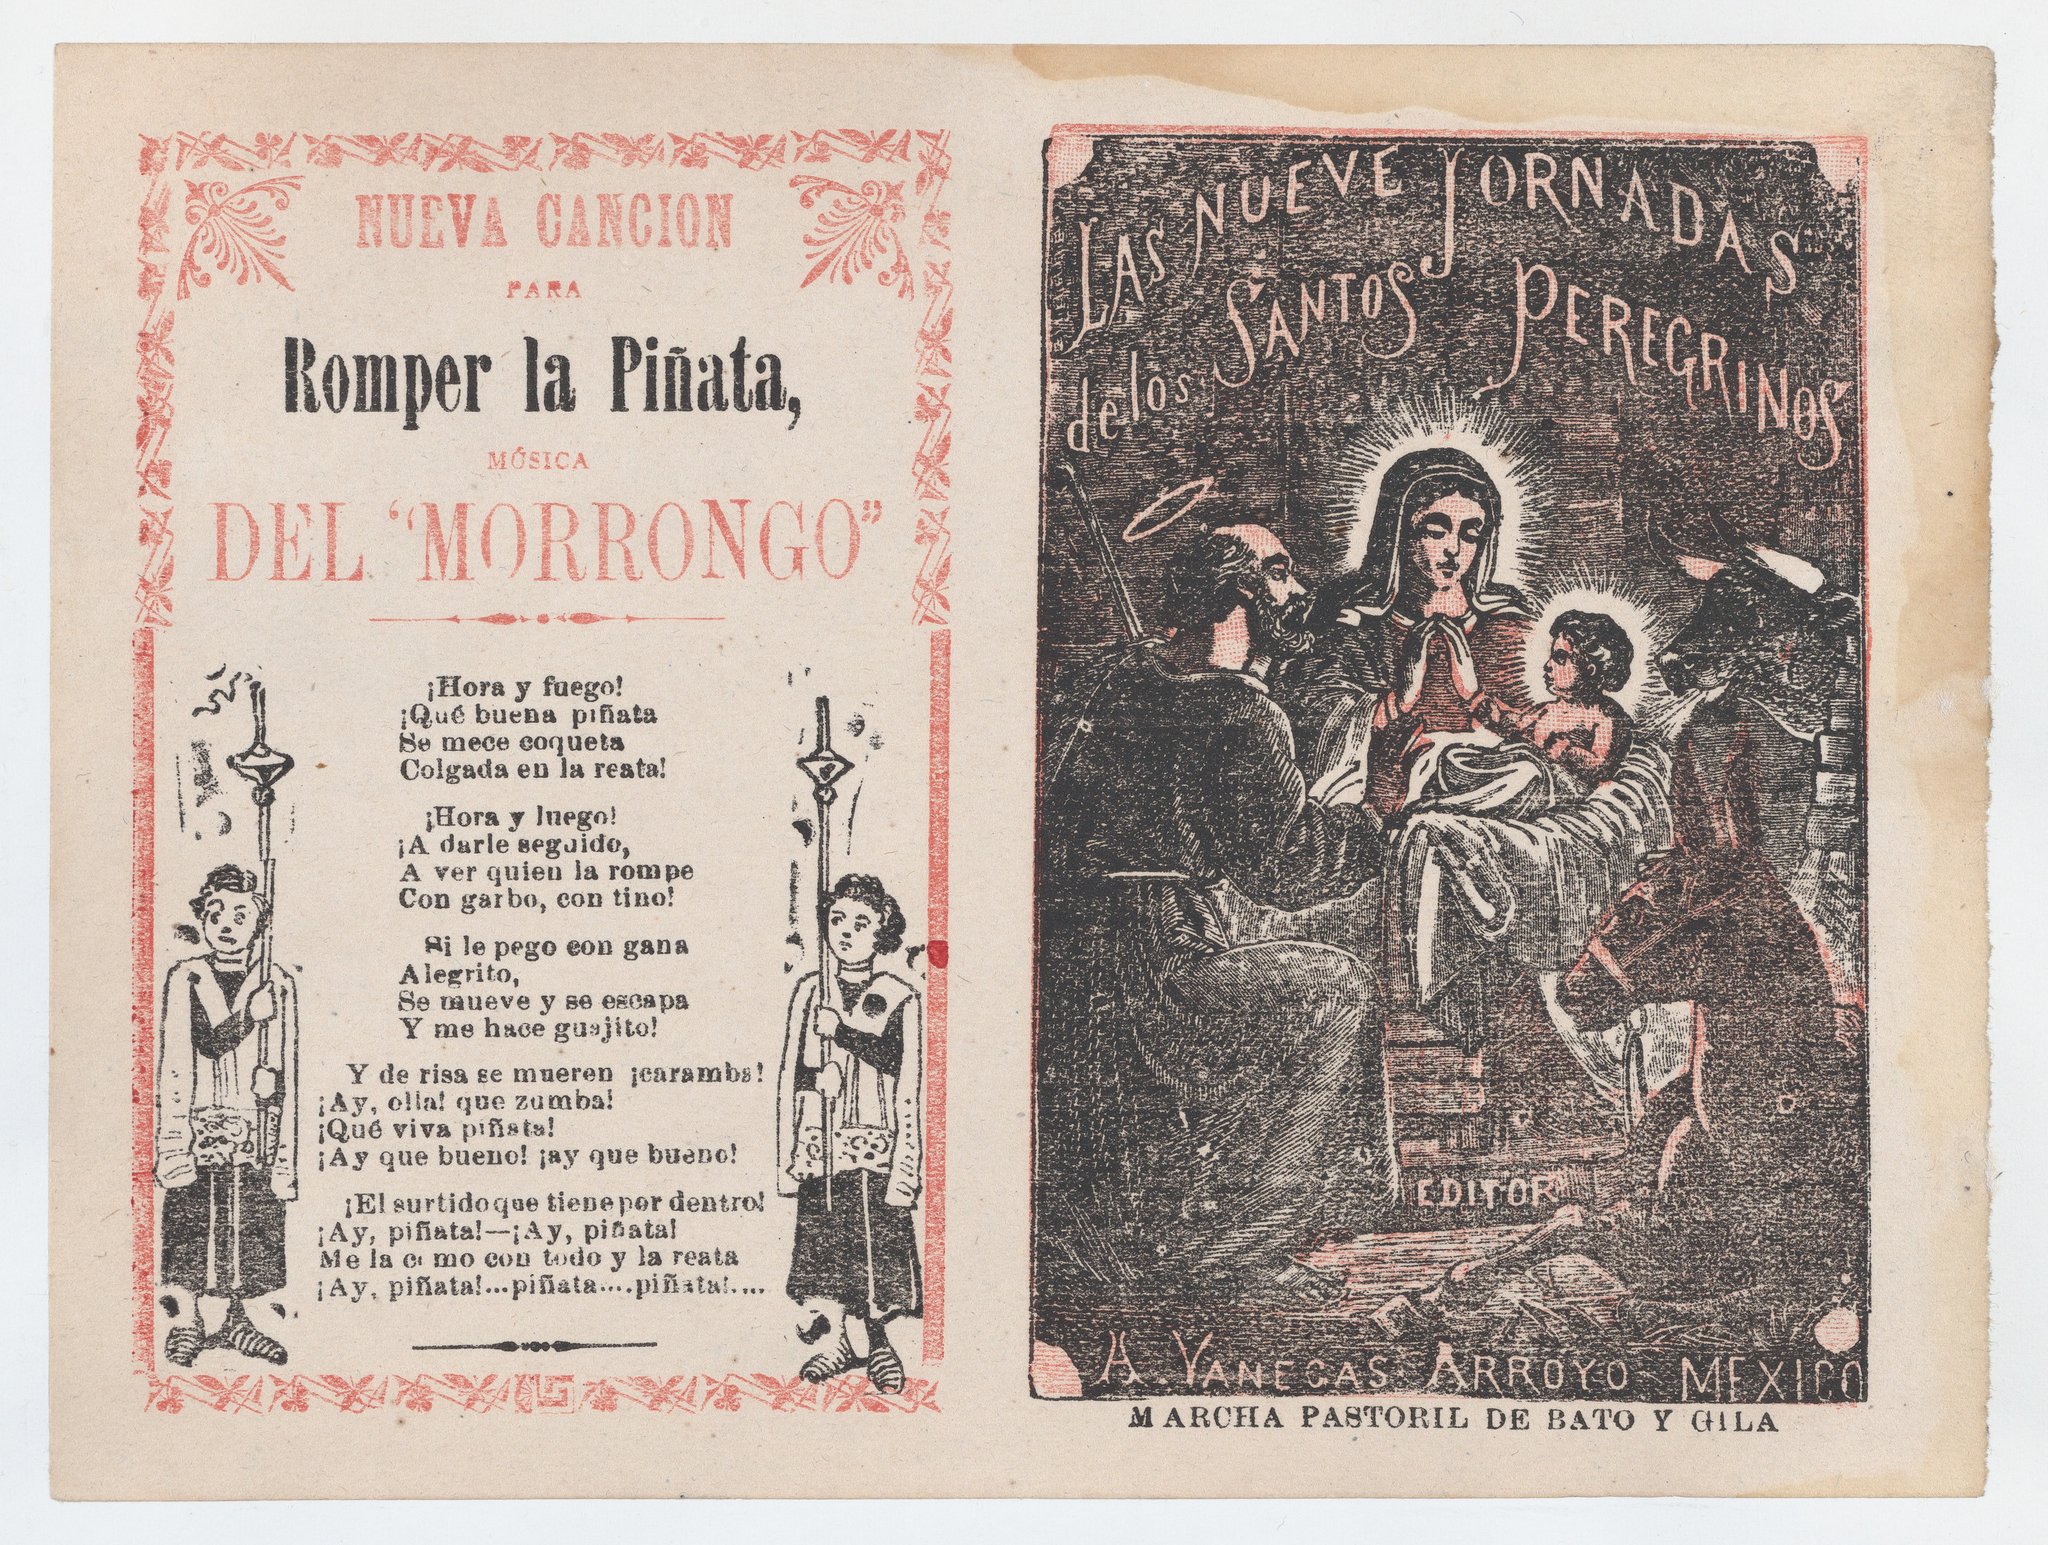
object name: print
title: Cover for 'Las Nueve Jornadas de los Santos Peregrinos', Holy Family in the manger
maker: josé guadalupe posada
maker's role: artist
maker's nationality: mexican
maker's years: 1852-1913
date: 1890-1910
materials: metal, paper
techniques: engraving, letterpress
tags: donkeys,christ,holy family,saint joseph,virgin mary